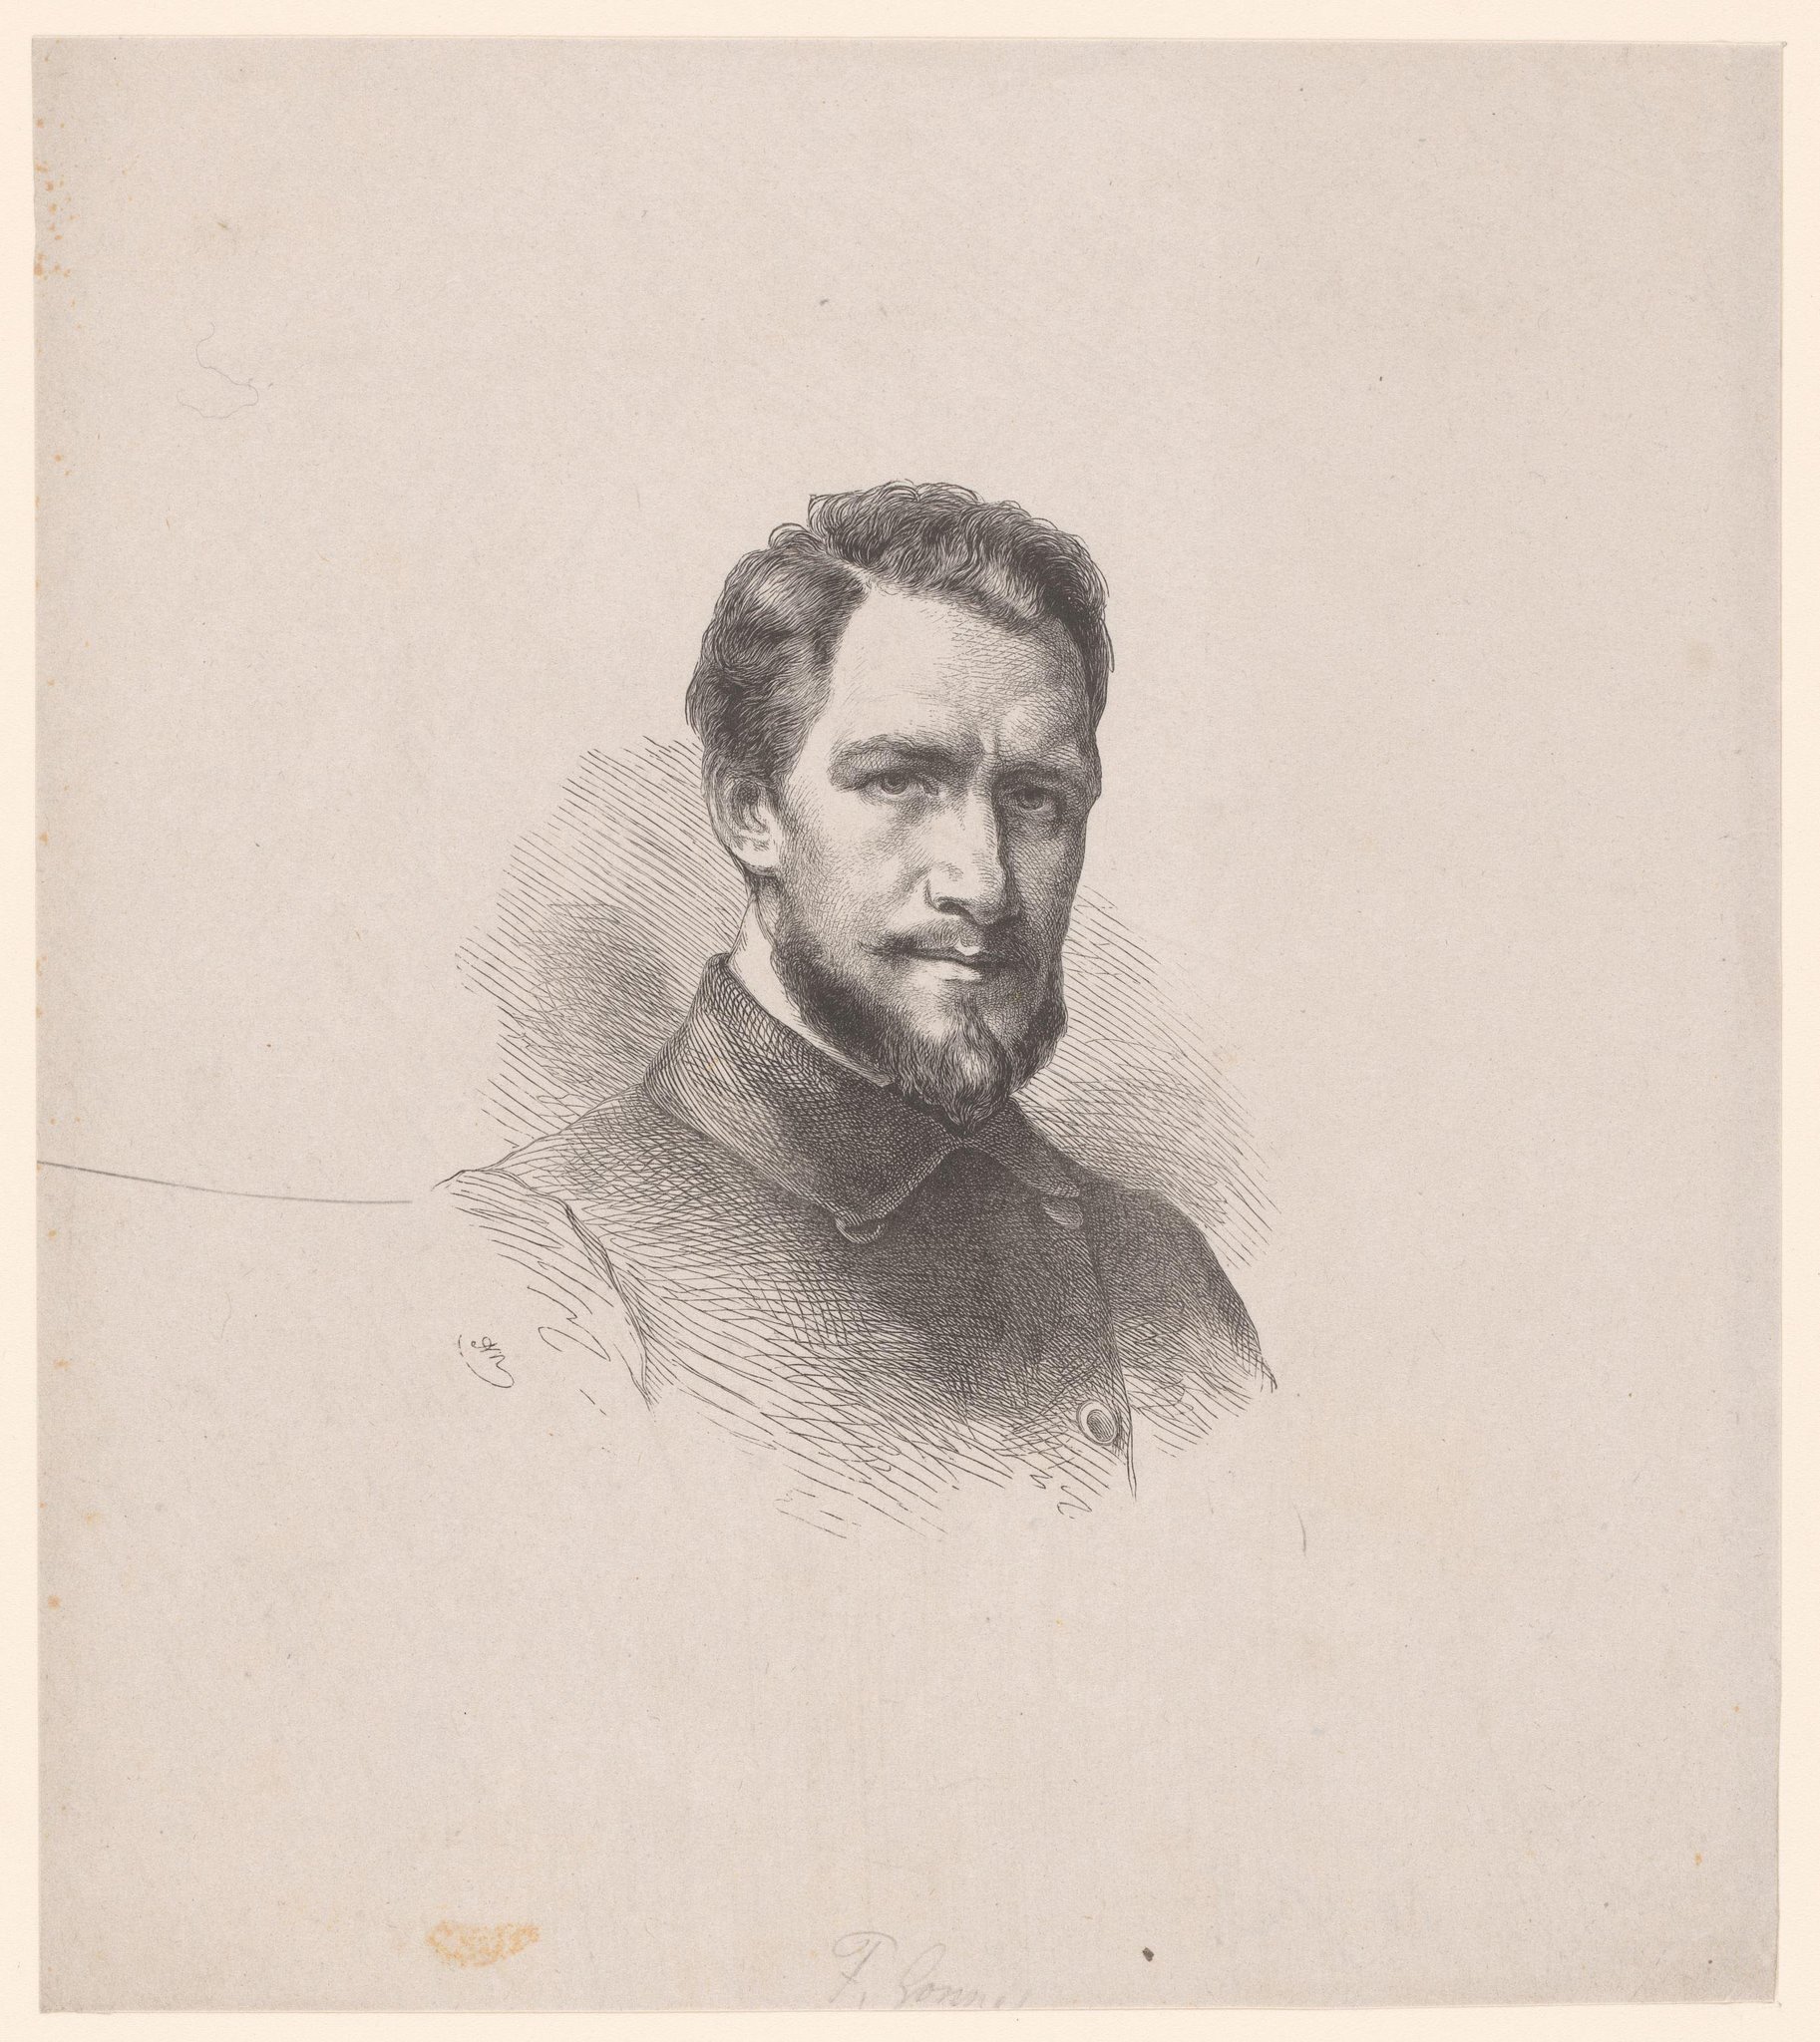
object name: print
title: Portret van Christian Friedrich Gonne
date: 1830-1860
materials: paper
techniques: engraving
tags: painter, historical persons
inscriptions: collector's mark: Lugt 2228